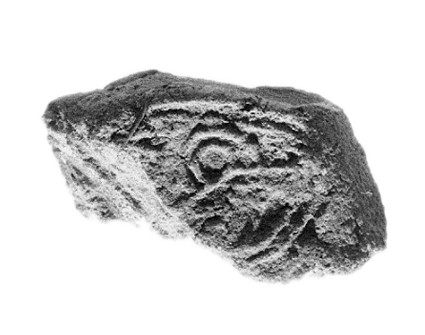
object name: sealing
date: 1981-1640 BCE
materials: mud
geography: egypt